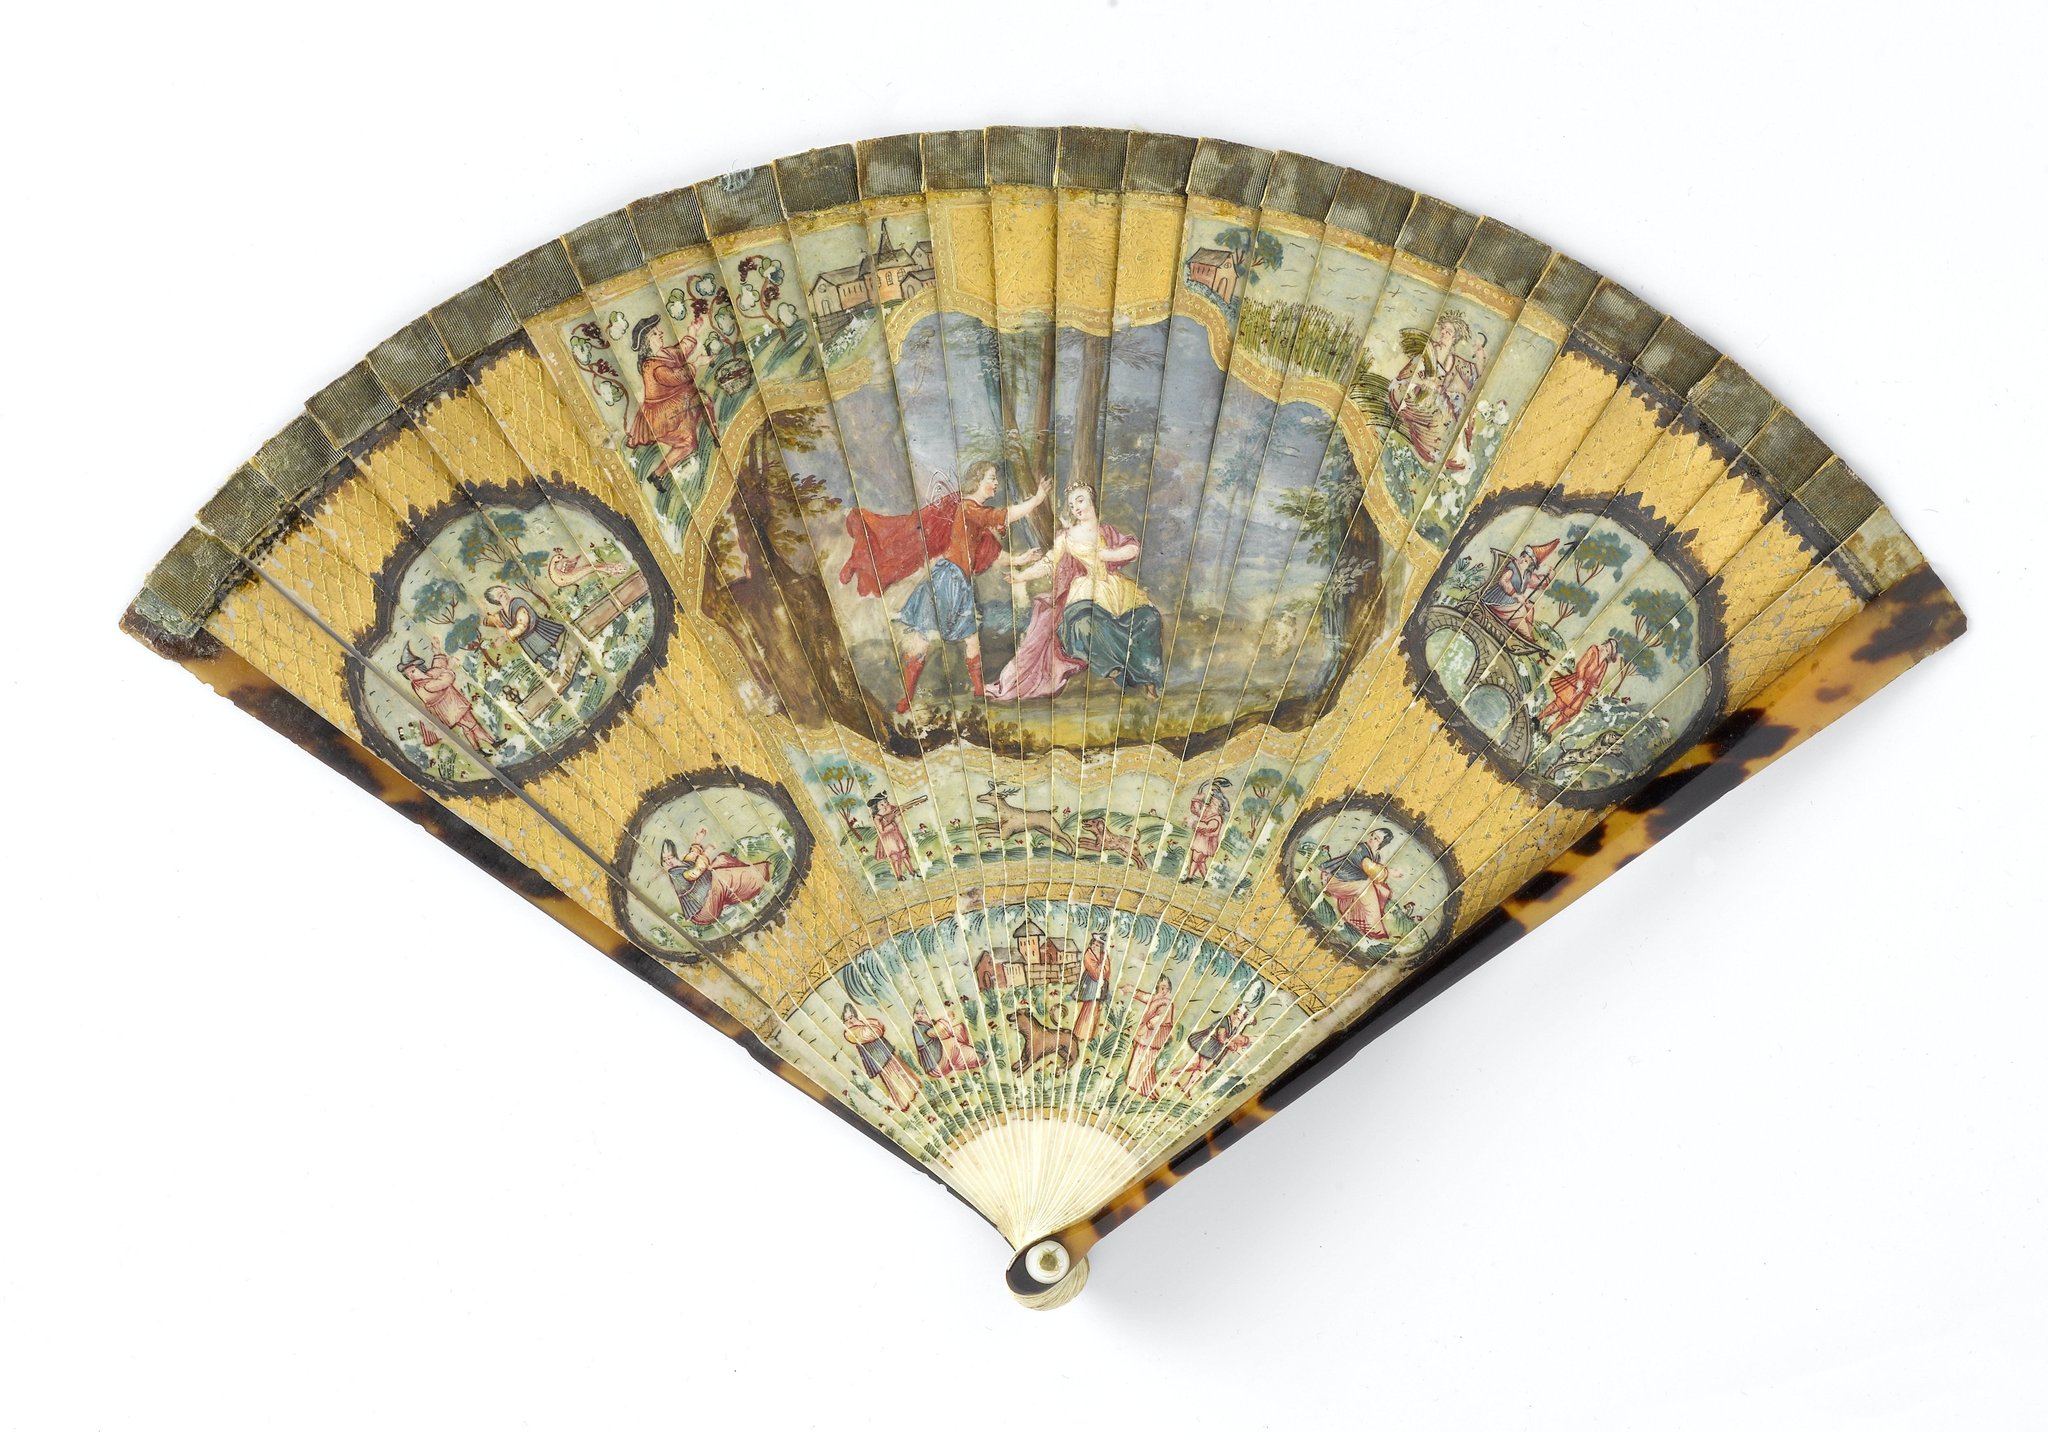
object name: brisé fan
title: Brisé-waaier van ivoor, beschilderd met tempera en goudverf, met centrale cartouche waarin Zephyros en Flora, omgeven door Chinoiserieën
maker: Anonymous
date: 1720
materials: copper, paint, ivory, mother of pearl, shell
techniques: cutting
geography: netherlands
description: Brisé-waaier van ivoor met in centrale cartouche een mythologische voorstelling in een landschap. De vier omringende cartouches en de afbeelding op het handdeel verbeelden chinoiserieën. De waaier is beschilderd met tempera en goudverf. De achterkant heeft een zelfde soort voorstelling, maar is minder uitgewerkt. De 30 benen zijn aaneengesloten en door een lint bijeengehouden. De buitenbenen zijn van schildpad. Bij de koperen sluitpin een parelmoeren schijfje.